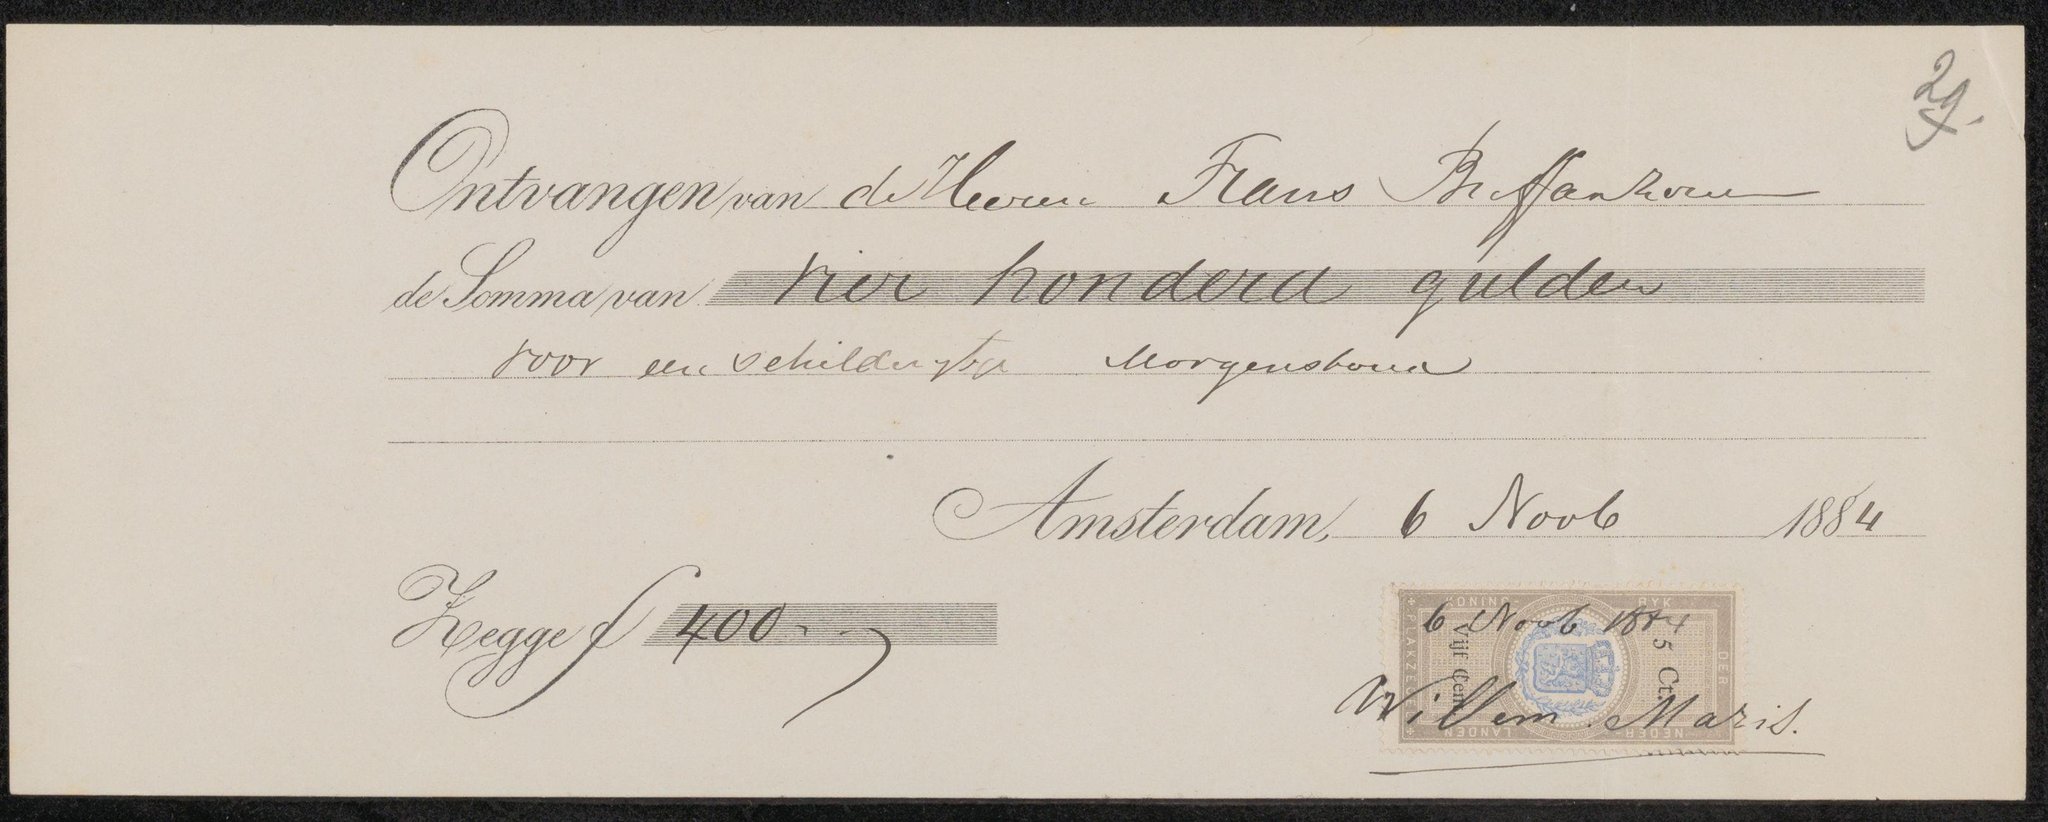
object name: ontvangstbewijs, kwitantie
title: Kwitantie voor Willem Maris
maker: willem maris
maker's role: draughtsman, painter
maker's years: 1844-1910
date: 1884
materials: ink, paper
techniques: pen, printing, writing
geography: amsterdam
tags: art trade, art shop, painting (including book-illumination, miniature-painting), money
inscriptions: collector's mark: Lugt 2233, collector's mark: Lugt 2228